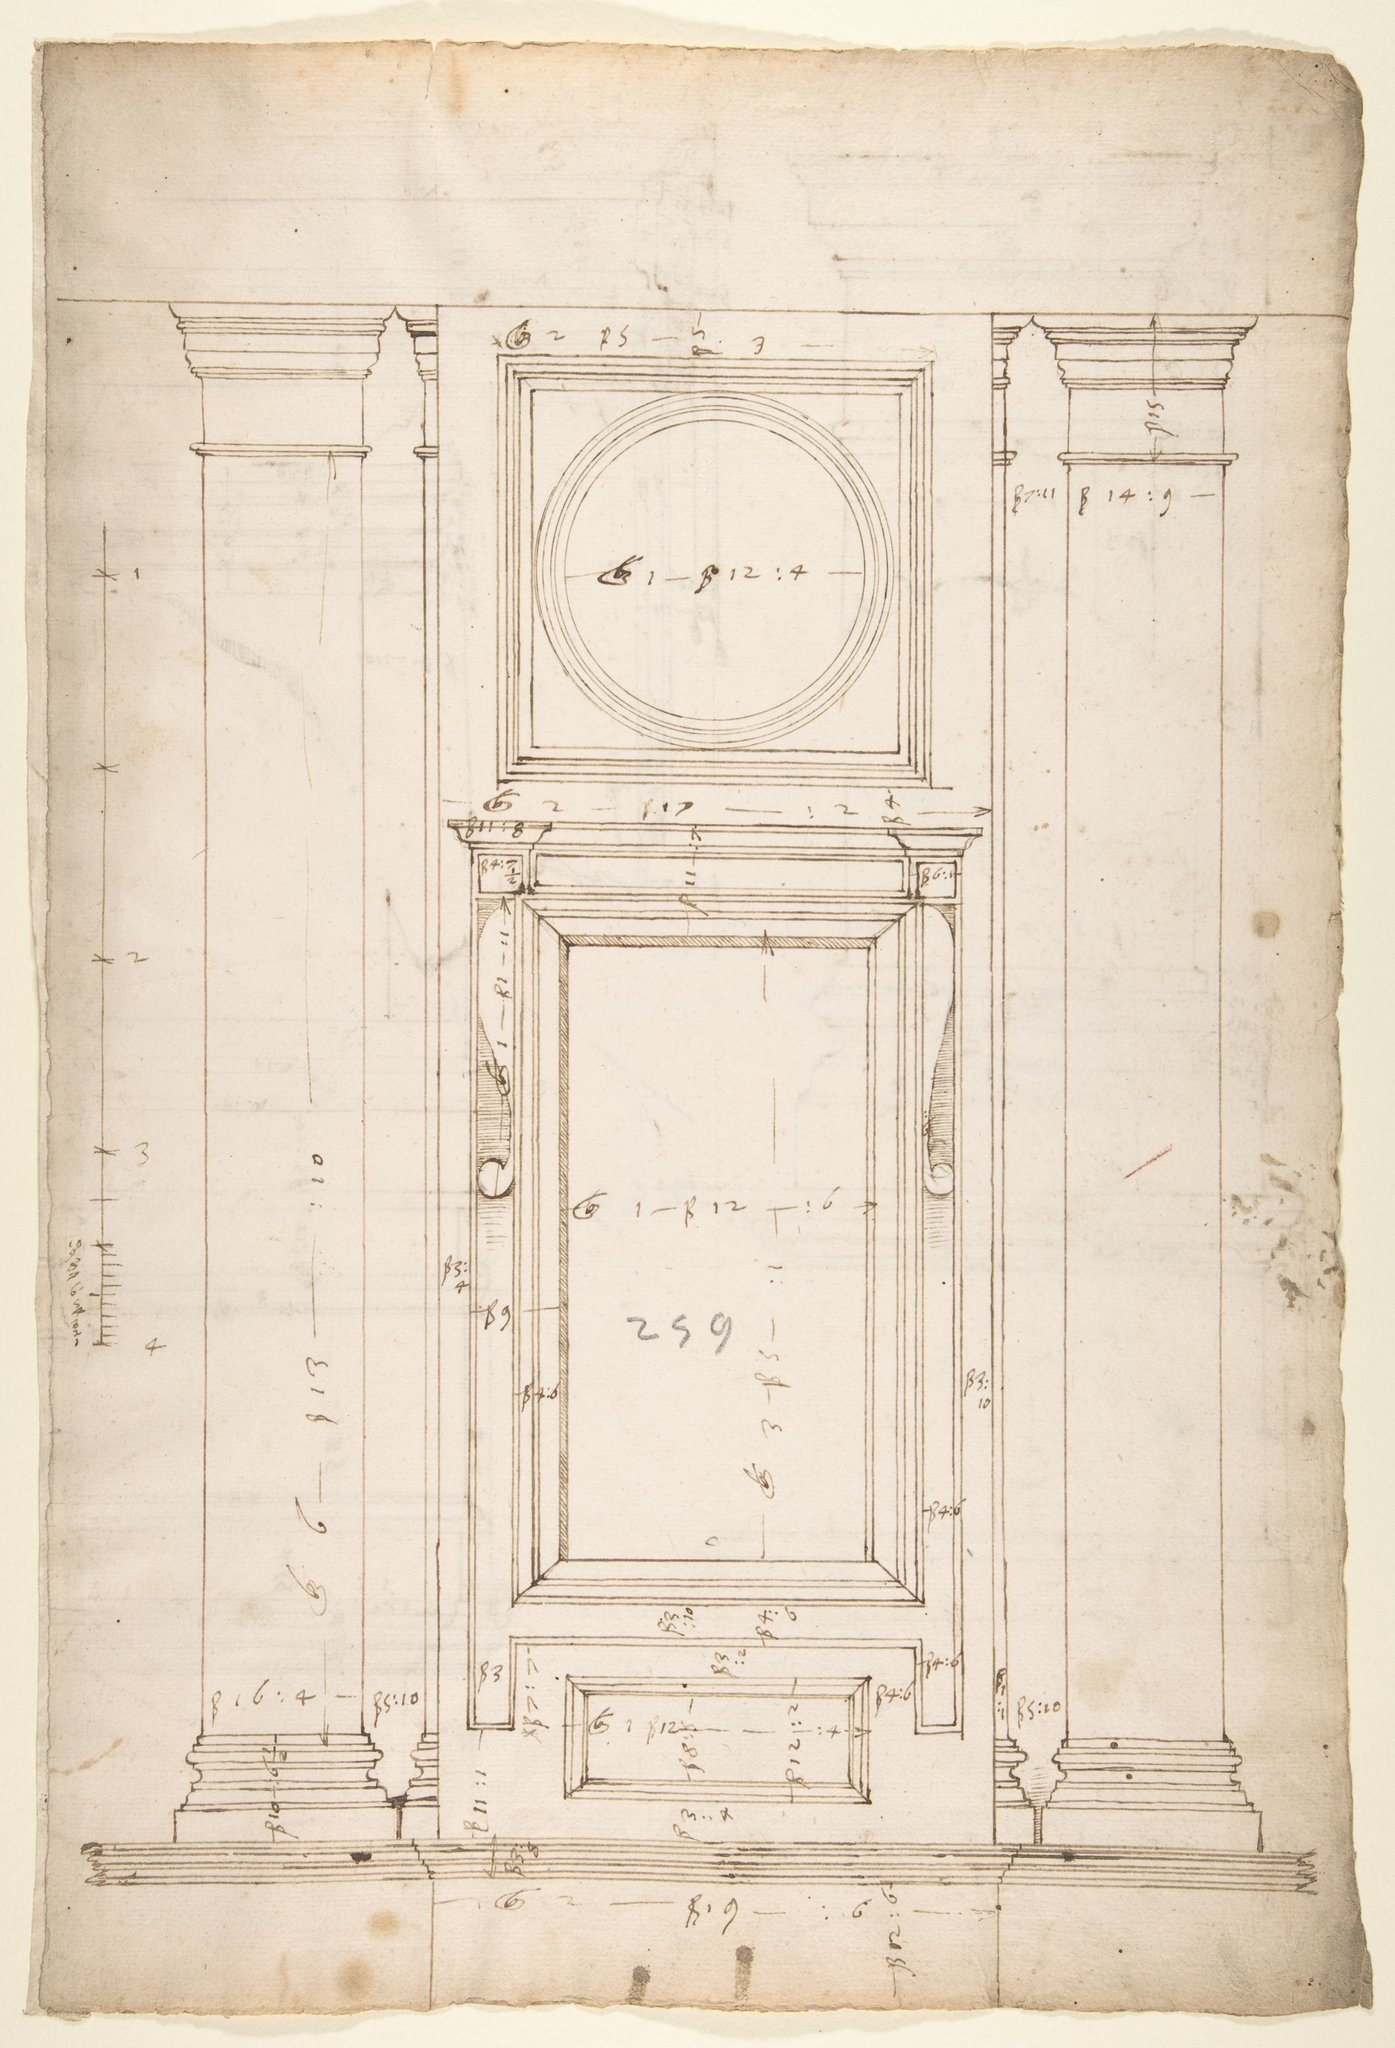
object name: drawing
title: San Lorenzo, Library, Ricetto, window, elevation (recto) San Lorenzo, Library, Ricetto, column, elevation; details, elevation (verso)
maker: anonymous, french, 16th century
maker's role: draftsman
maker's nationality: french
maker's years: 1500-1600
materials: chalk, ink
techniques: incising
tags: architecture,columns,windows